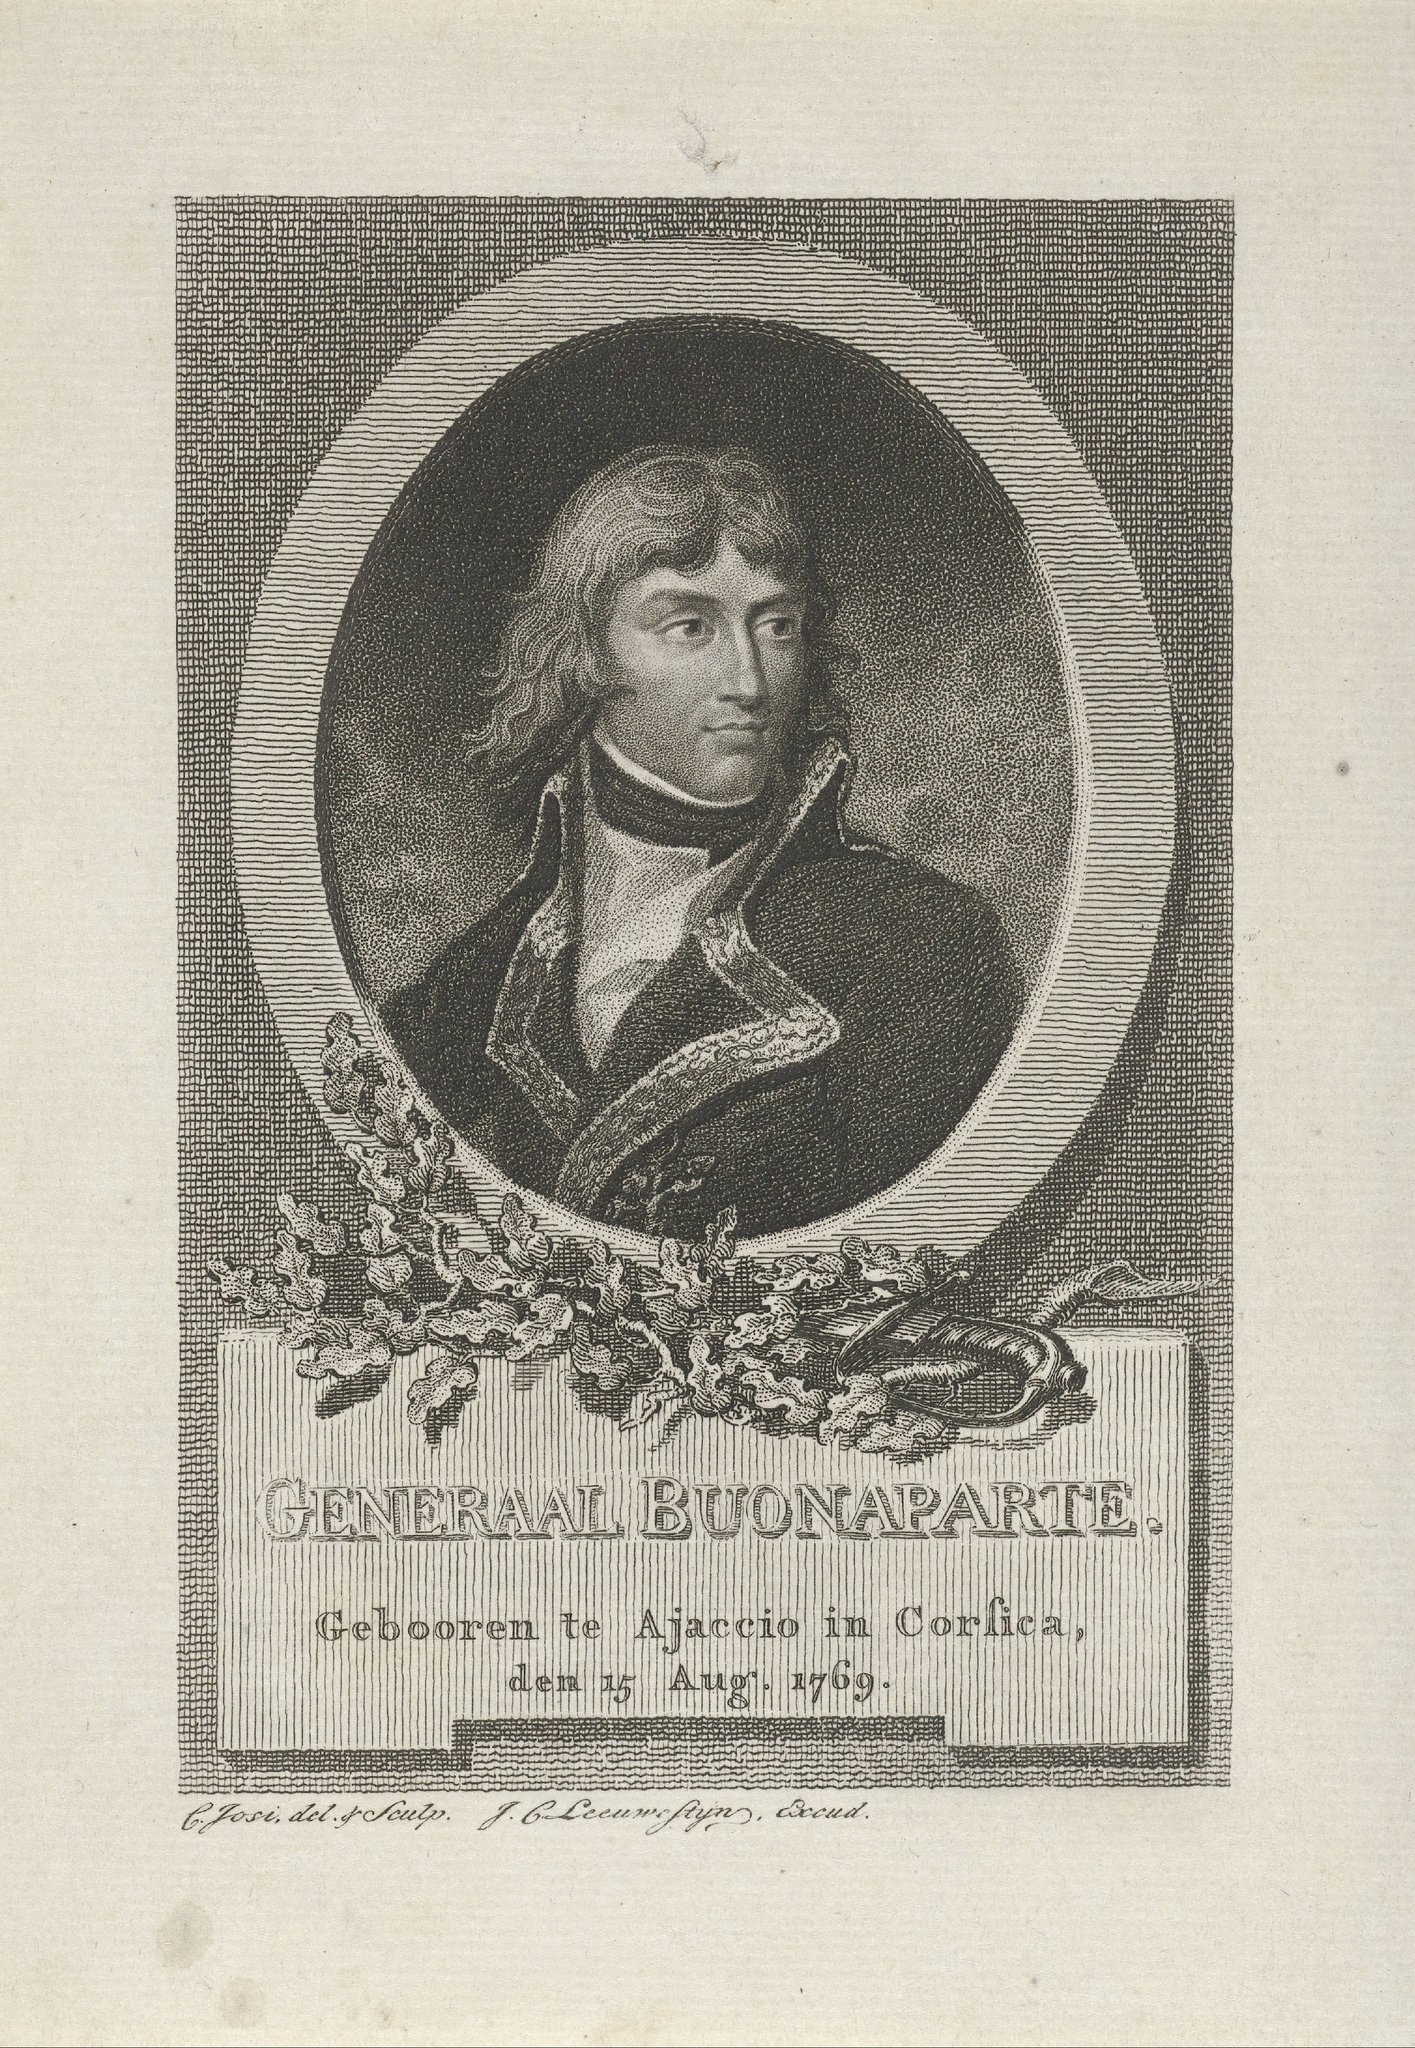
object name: print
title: Portret van Napoleon I Bonaparte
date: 1784-1828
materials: paper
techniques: engraving, etching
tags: napoleon i (emperor of the french)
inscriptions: collector's mark: Lugt 2228, collector's mark: Lugt 2760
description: Busteportret van Napoleon I Bonaparte, keizer der Fransen. Het portret is gevat in een ovale omlijsting met daaronder eikenbladeren. In het kader de naam van de geportretteerde en een tweeregelig onderschrift in het Nederlands.